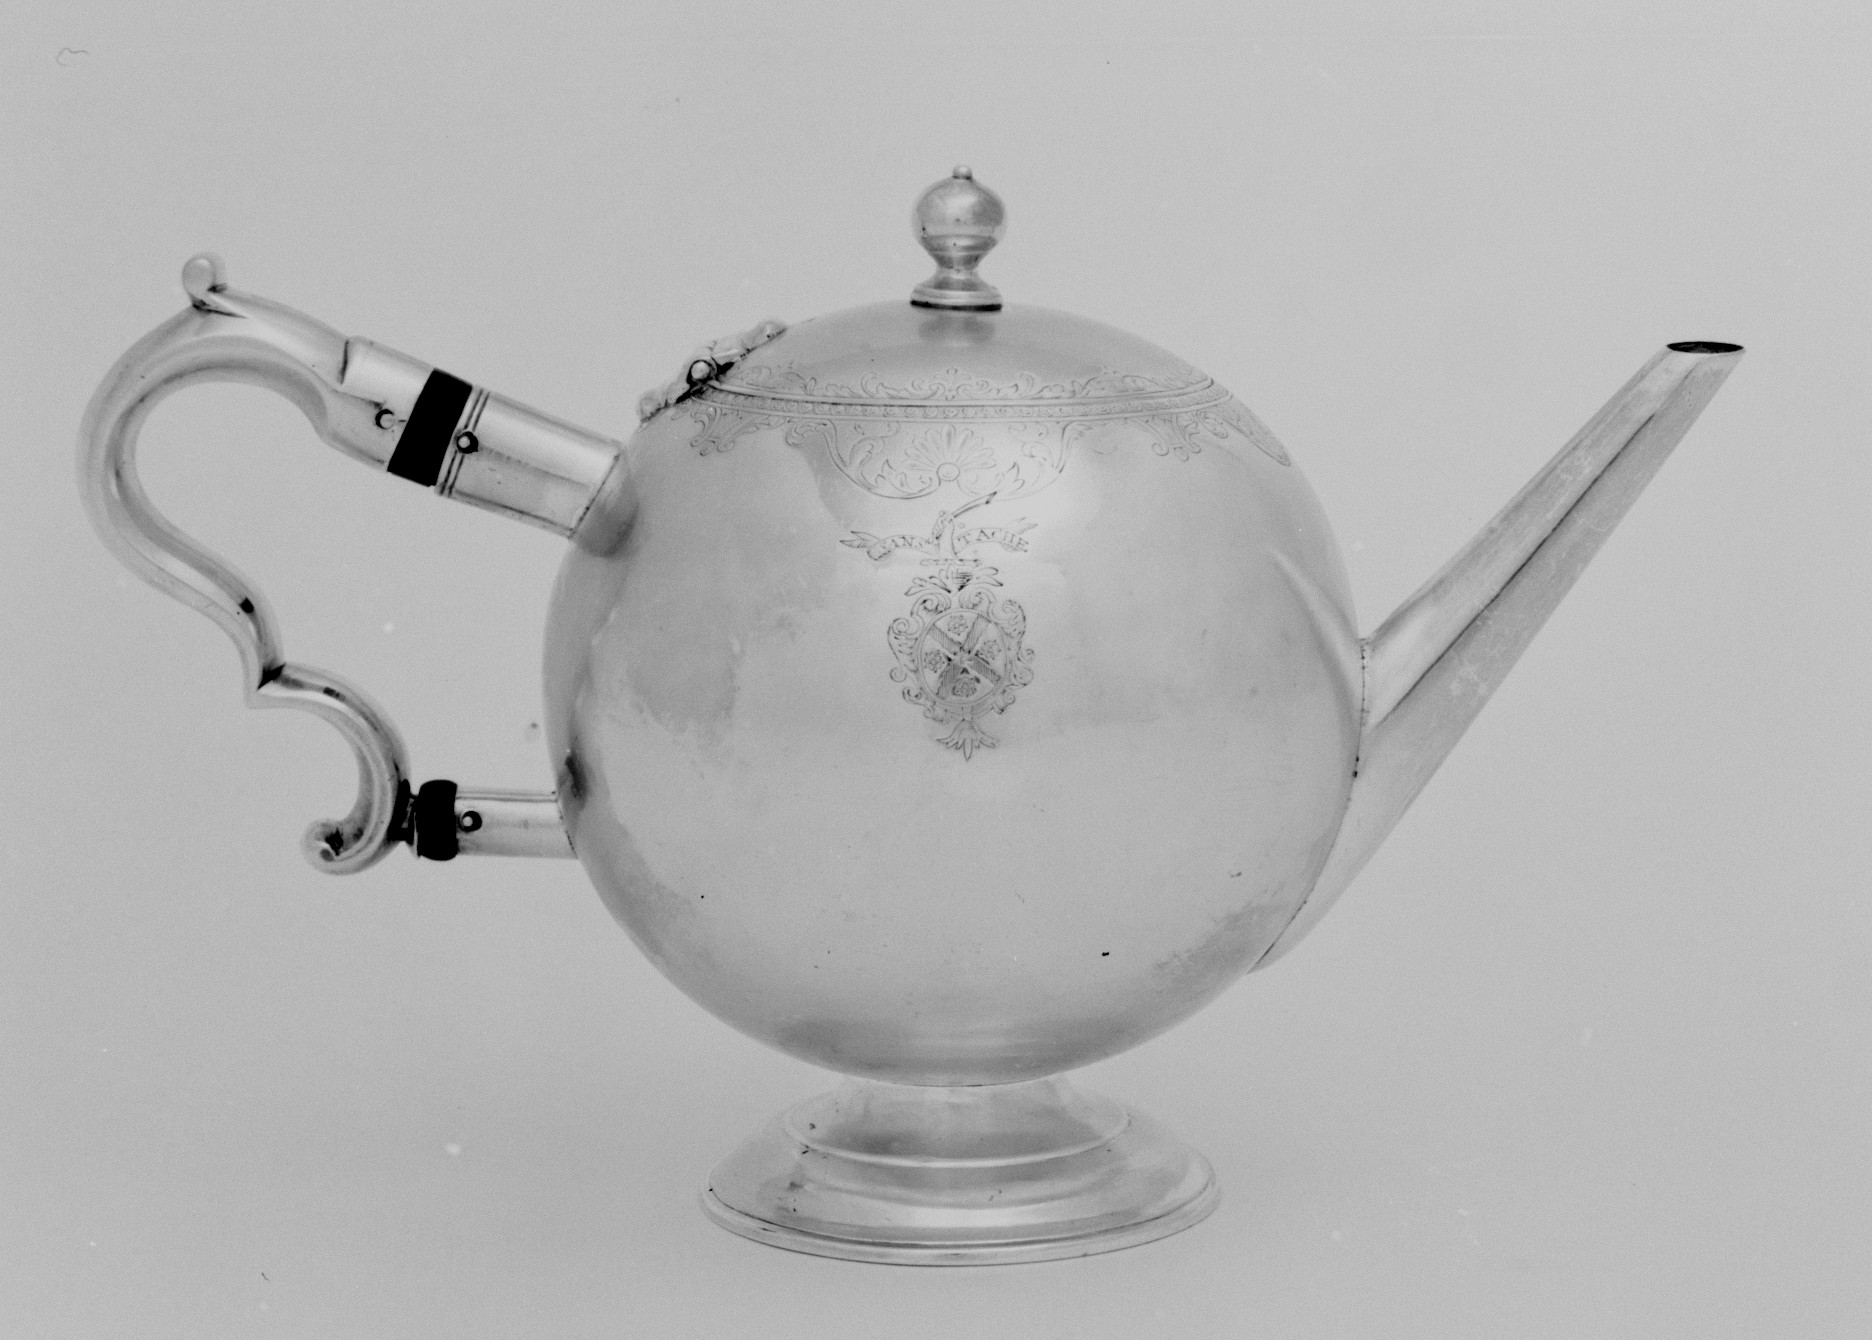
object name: teapot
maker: kenneth mckenzie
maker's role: maker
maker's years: 1714-1733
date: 1733-1734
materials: silver, wood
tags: coat of arms